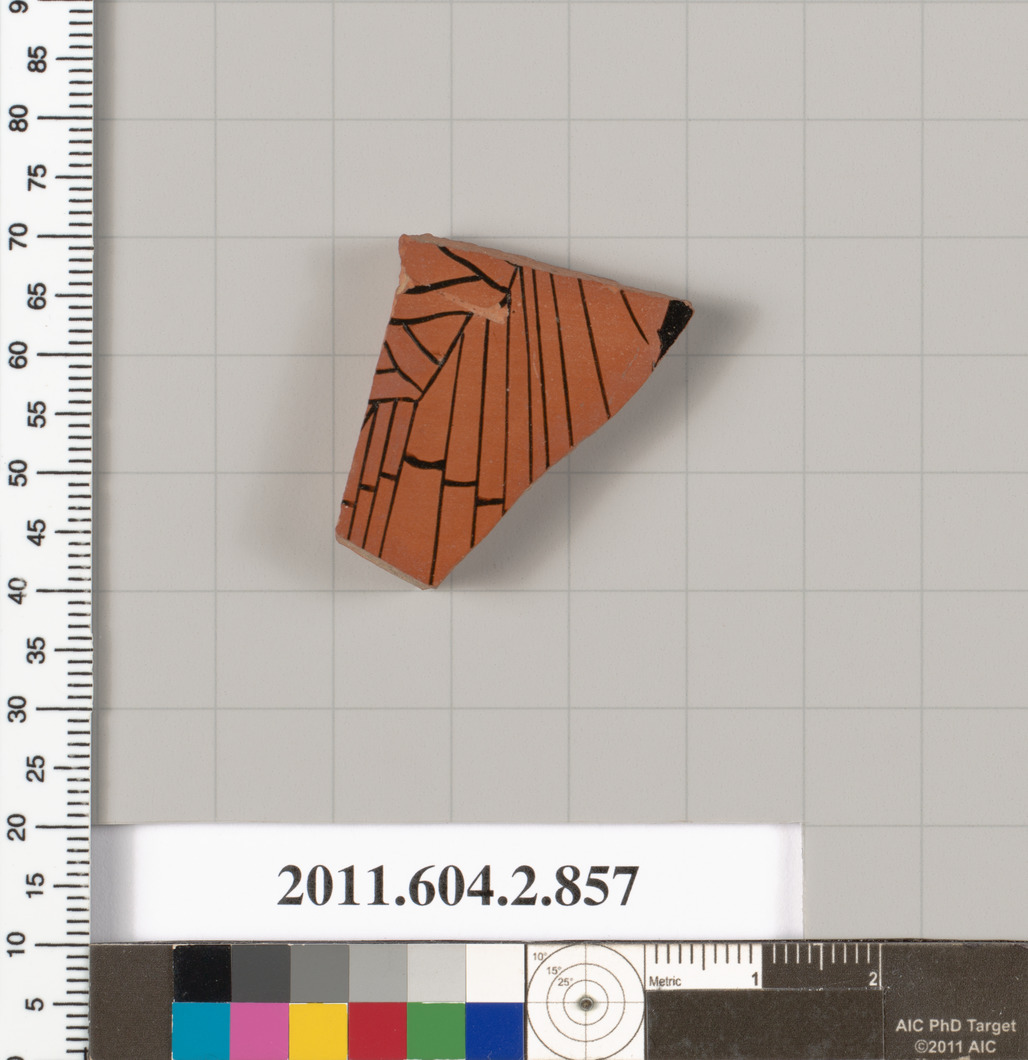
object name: bell krater fragment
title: Terracotta fragment of a bell-krater (bowl for mixing wine and water)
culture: greek, attic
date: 470-460 BCE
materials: terracotta